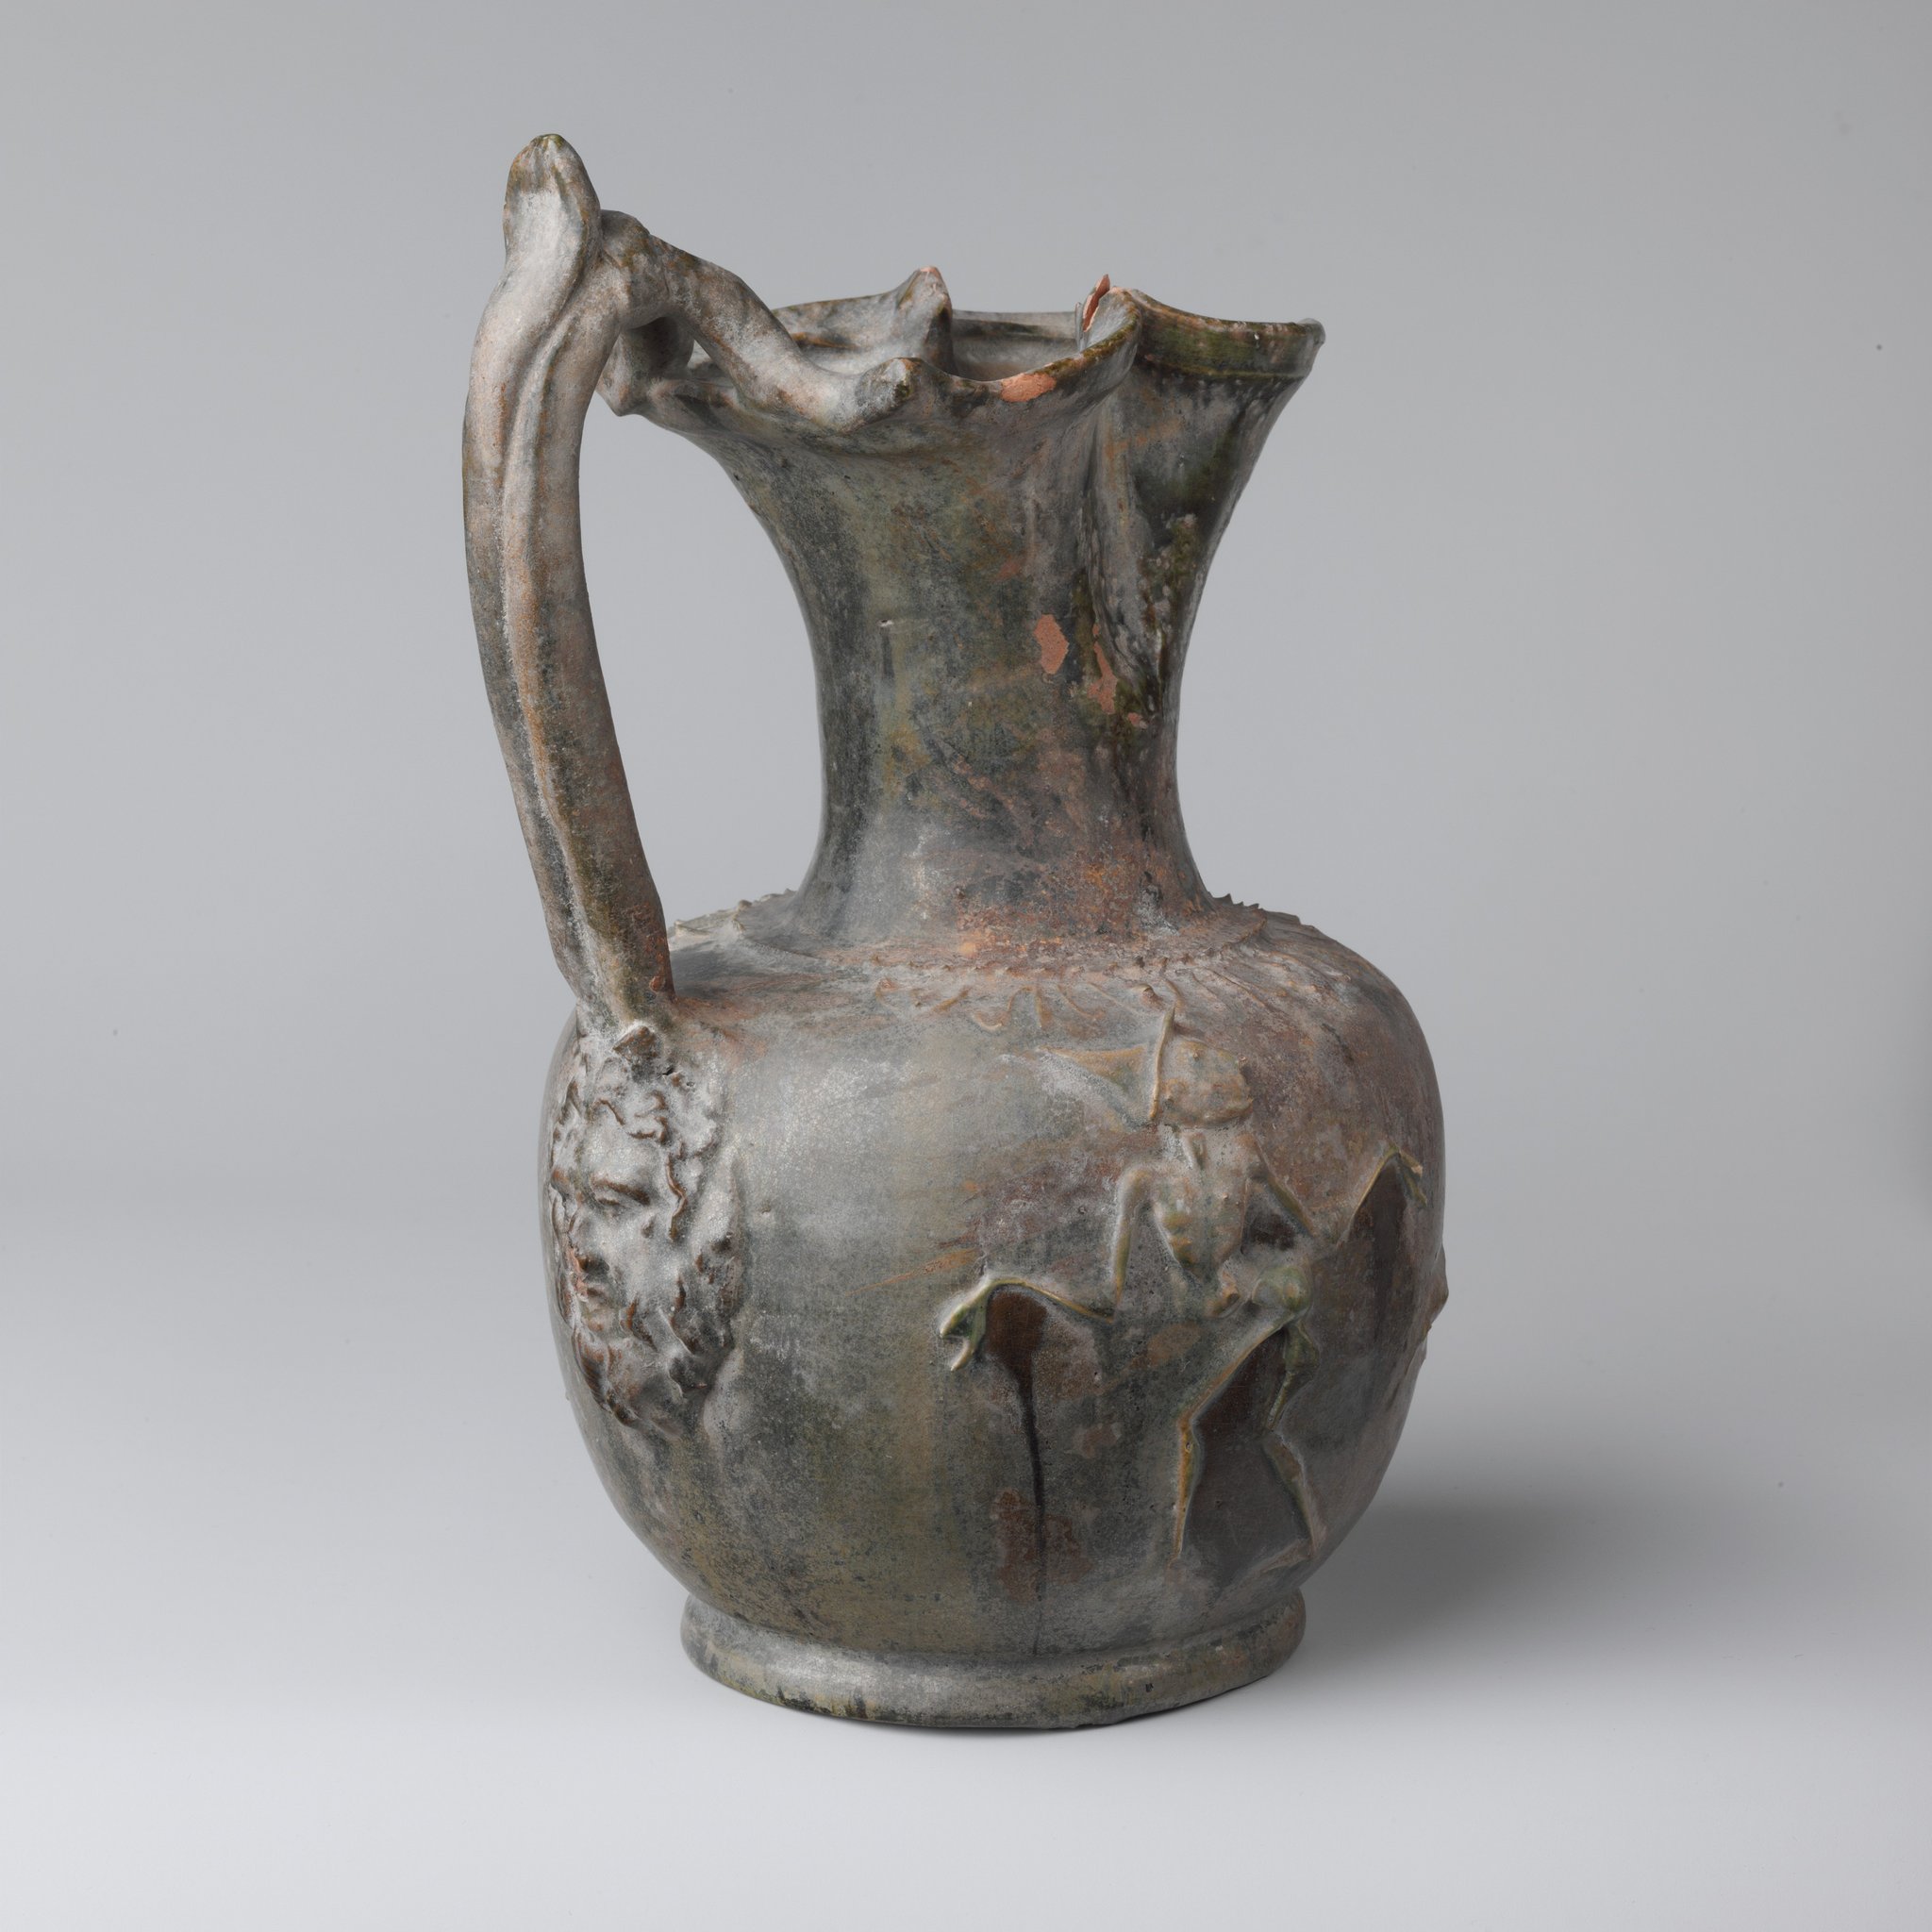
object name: jug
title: Terracotta jug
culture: roman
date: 50-1 BCE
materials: terracotta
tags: human figures